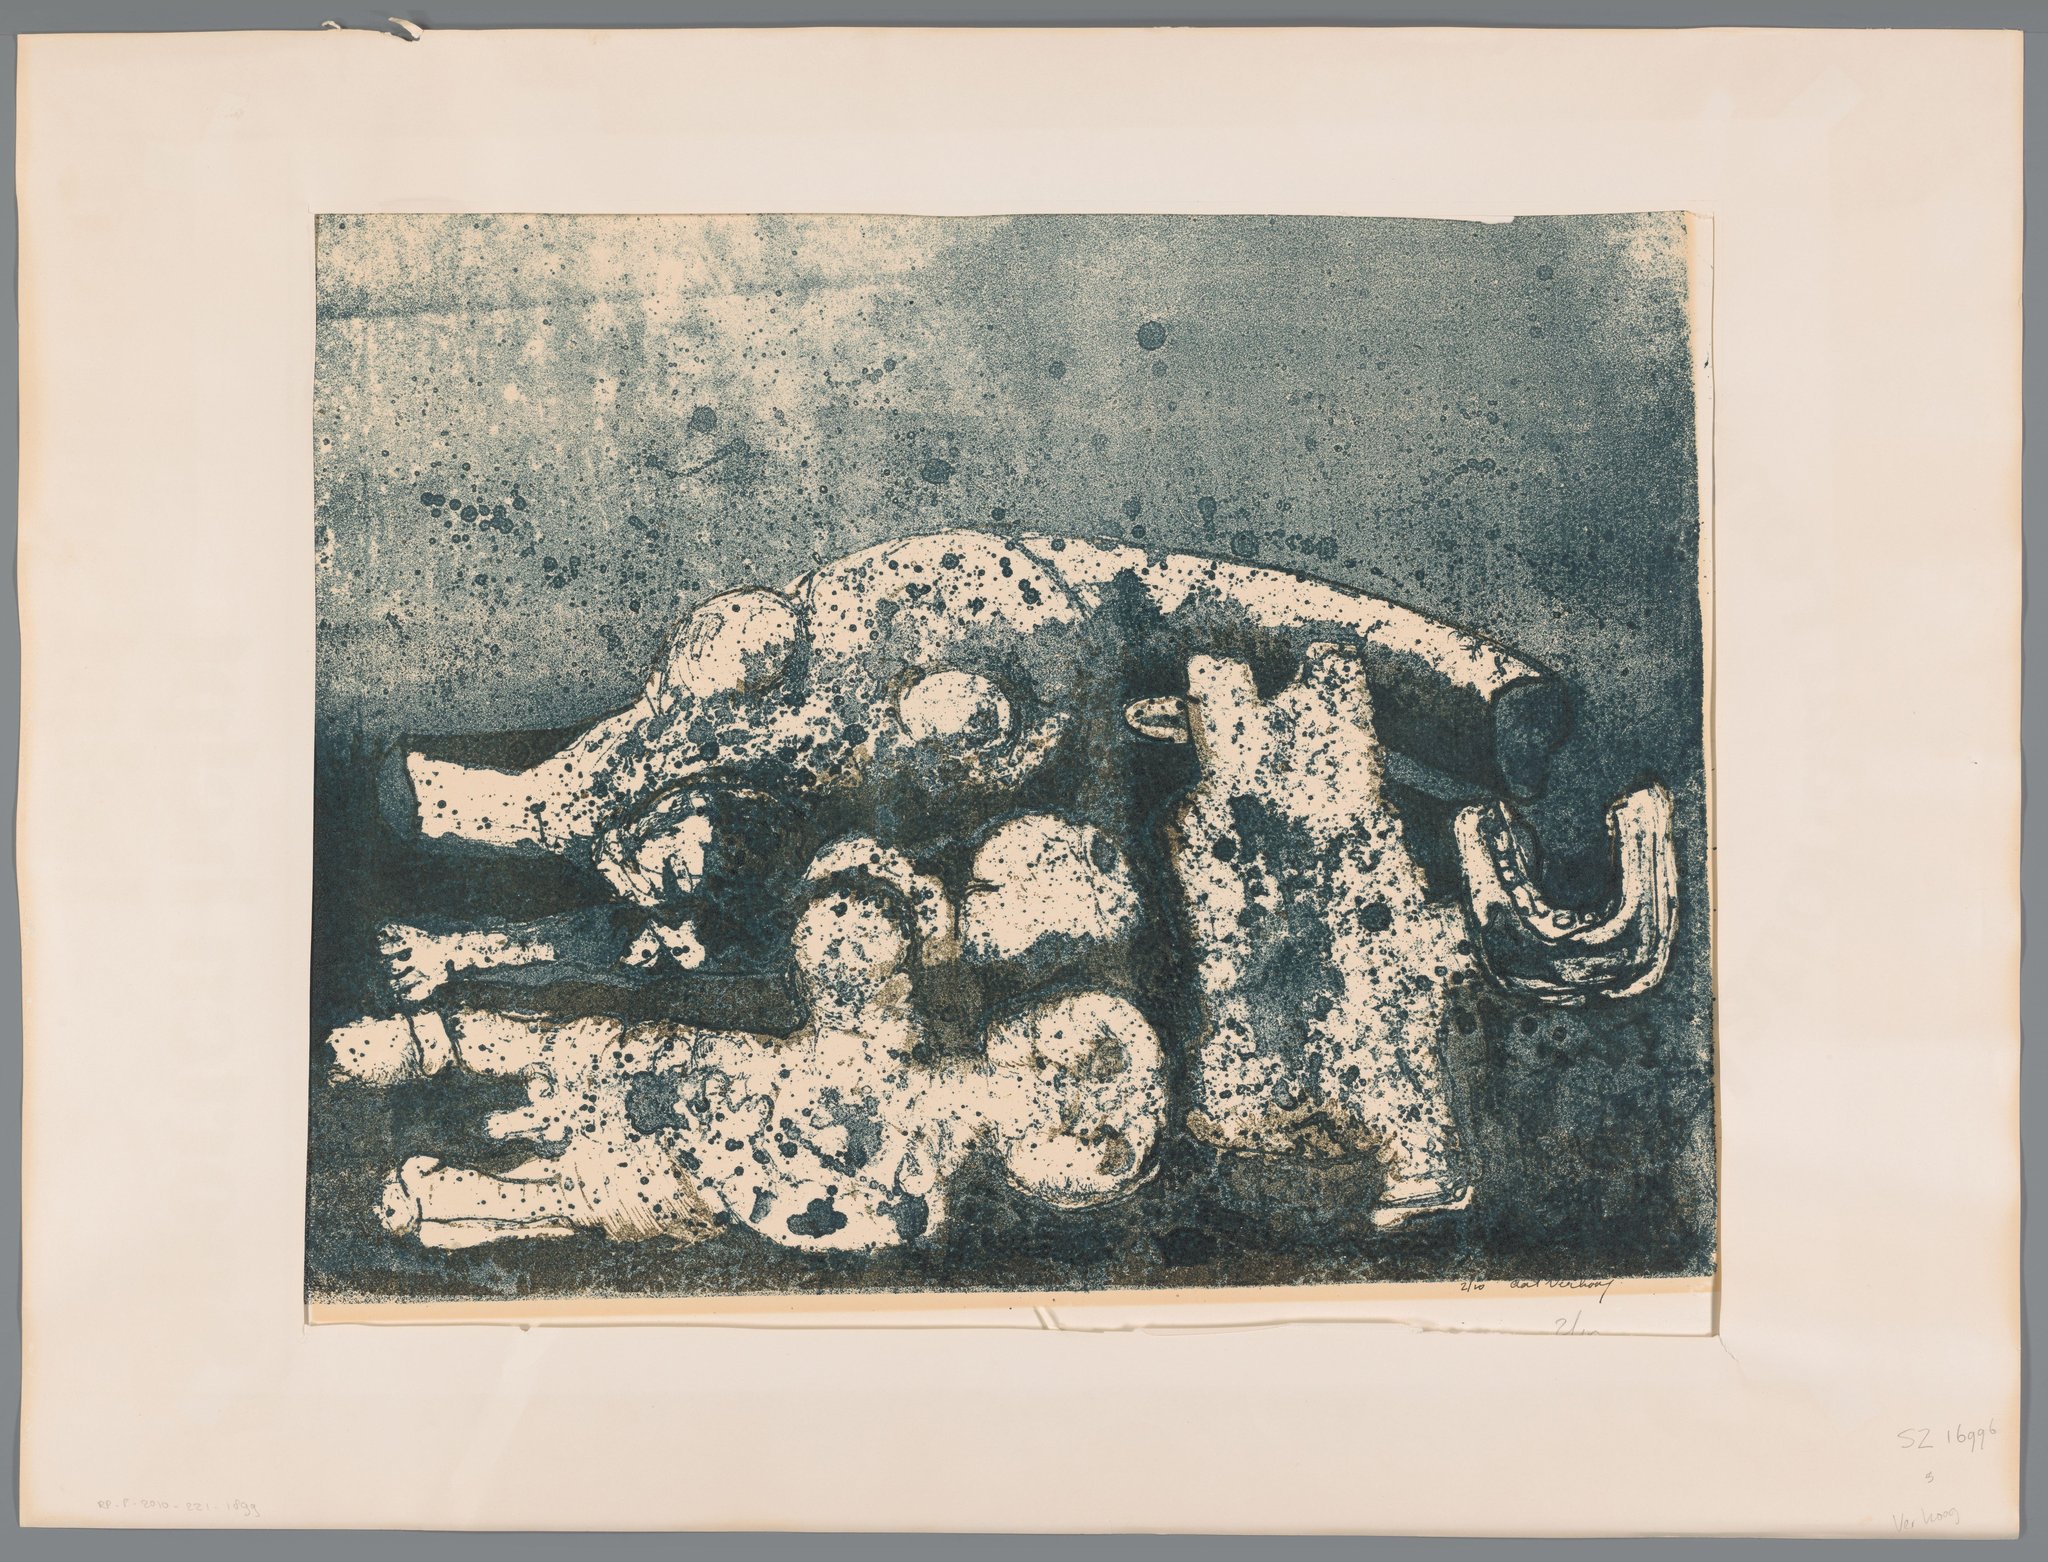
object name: print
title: Compositie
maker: aat verhoog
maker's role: print maker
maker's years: 1933-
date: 1962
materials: paper, ink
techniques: lithograph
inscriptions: signature: ‘Aat Verhoog’, edition: ‘2/10’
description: De huidige titel is door het Rijksmuseum overgenomen van het Instituut Collectie Nederland.